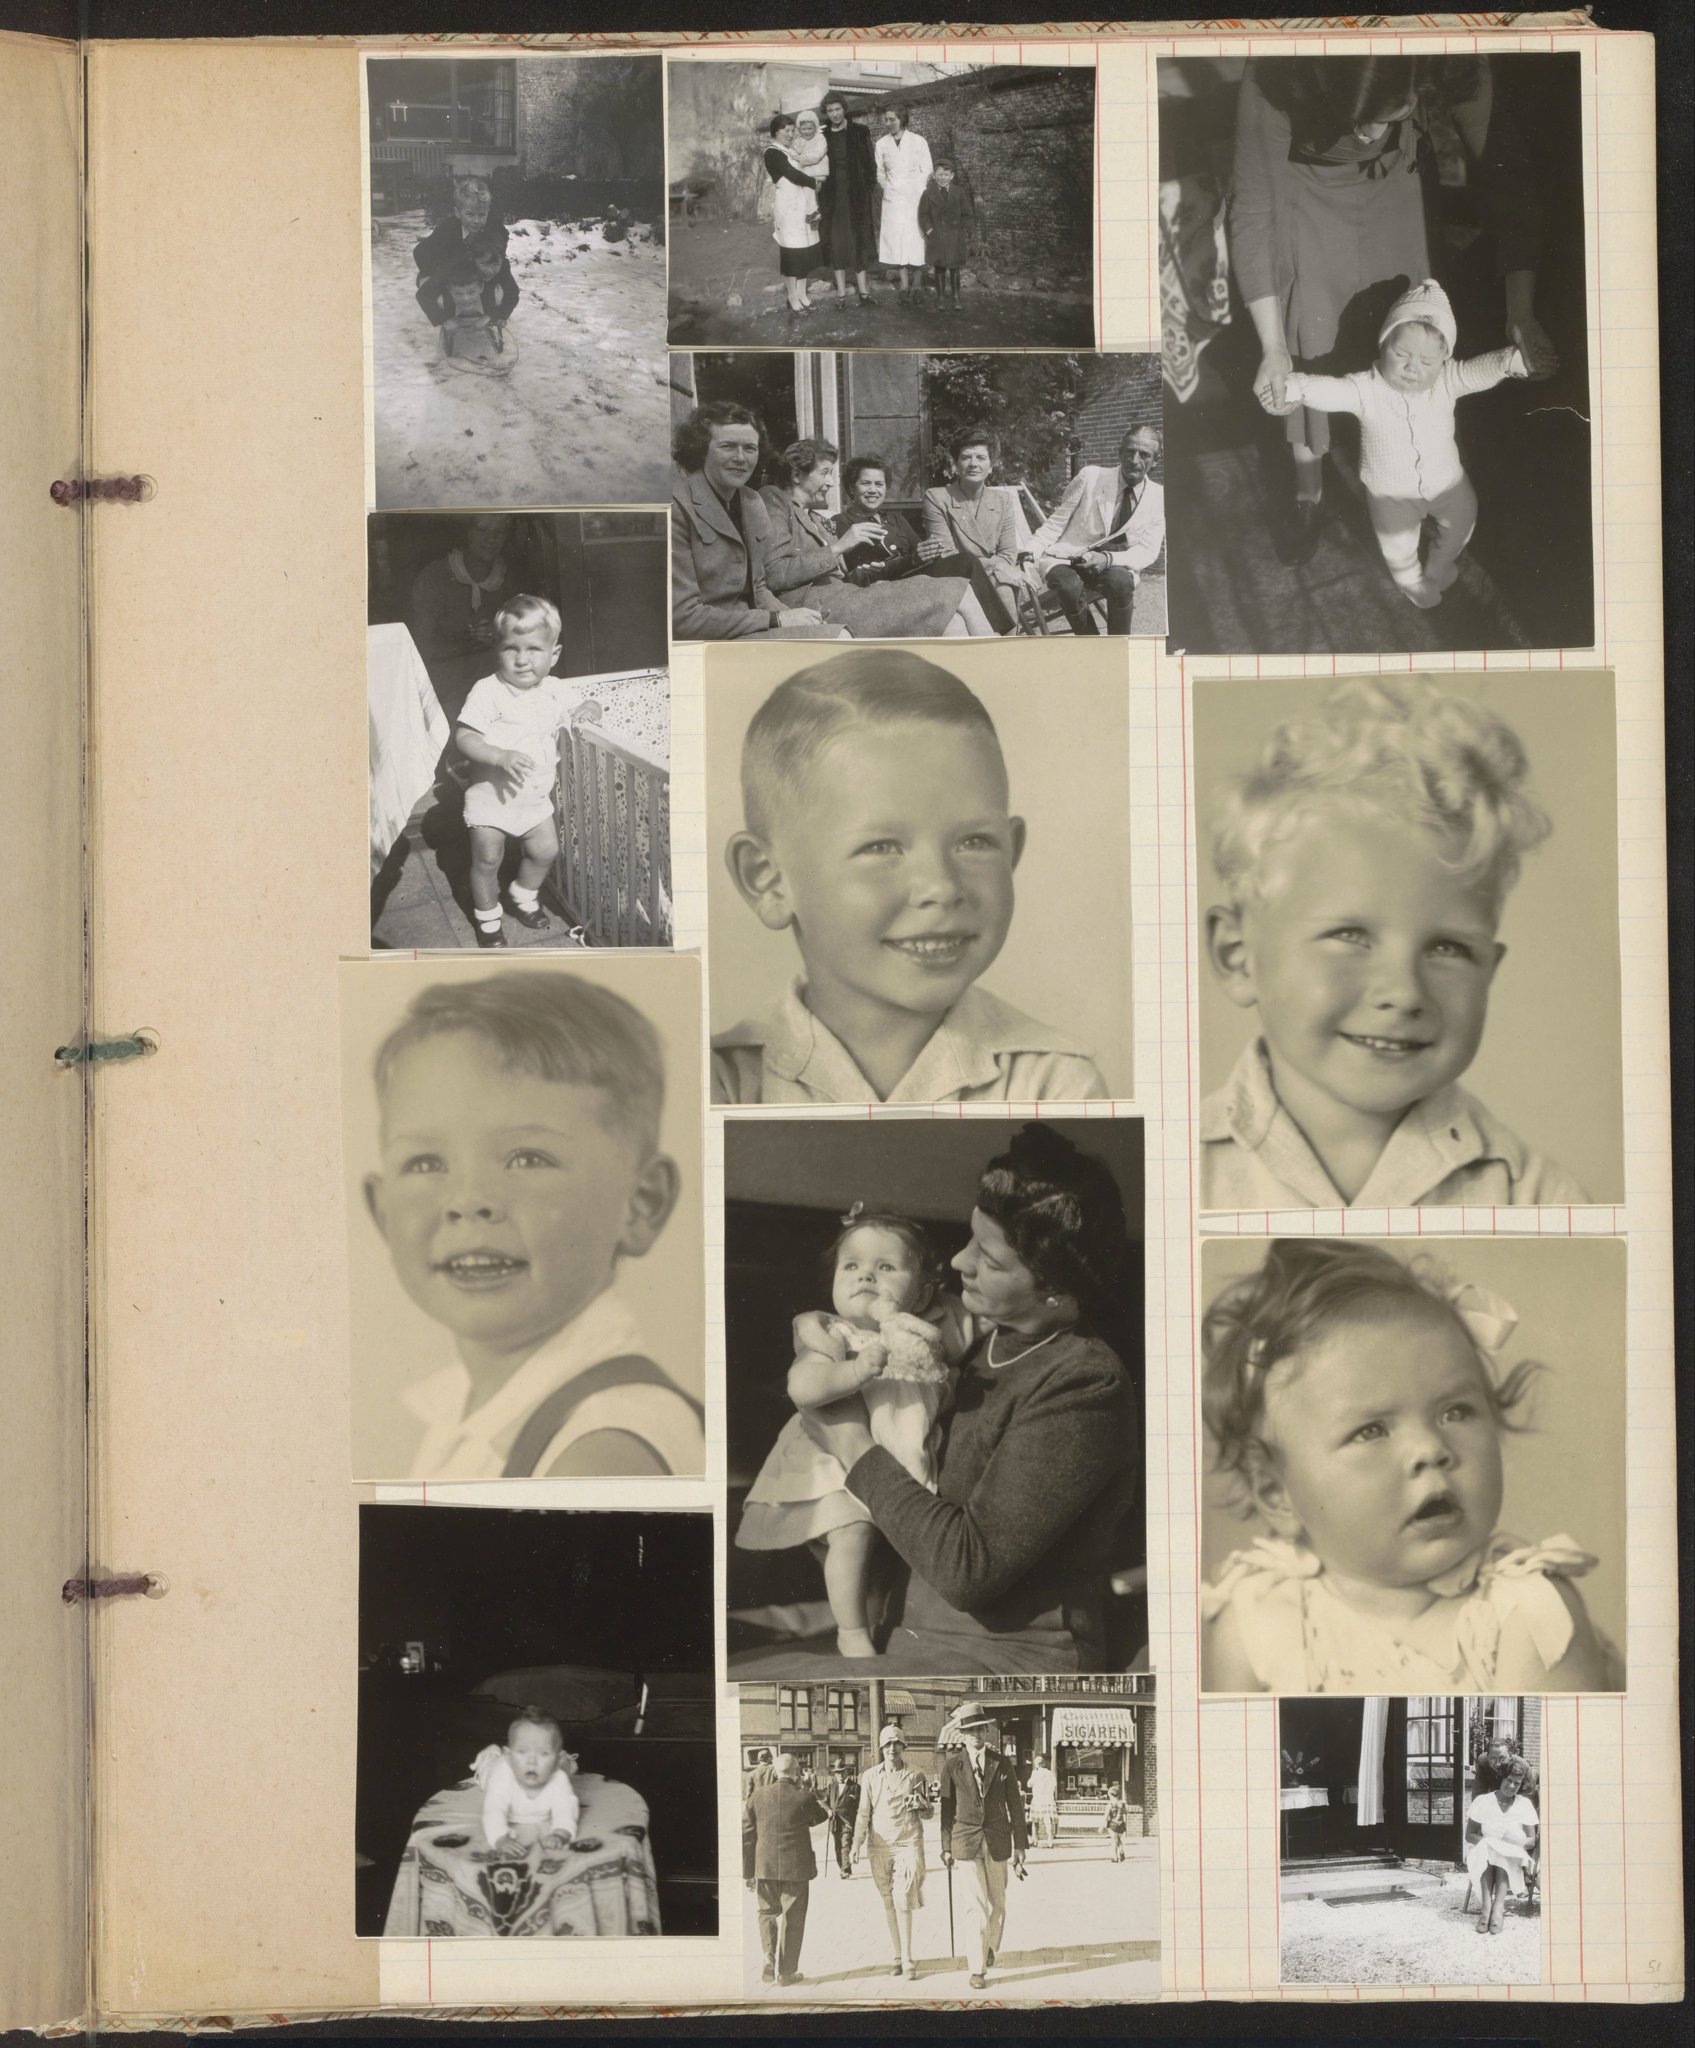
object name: photograph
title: Portretten van onbekende personen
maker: Anonymous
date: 1920-1940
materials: paper, photographic support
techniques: gelatin silver print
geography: netherlands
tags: child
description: Albumblad met portretten van voornamelijk jonge kinderen. Onderdeel van Fotoalbum van de familie Petri.